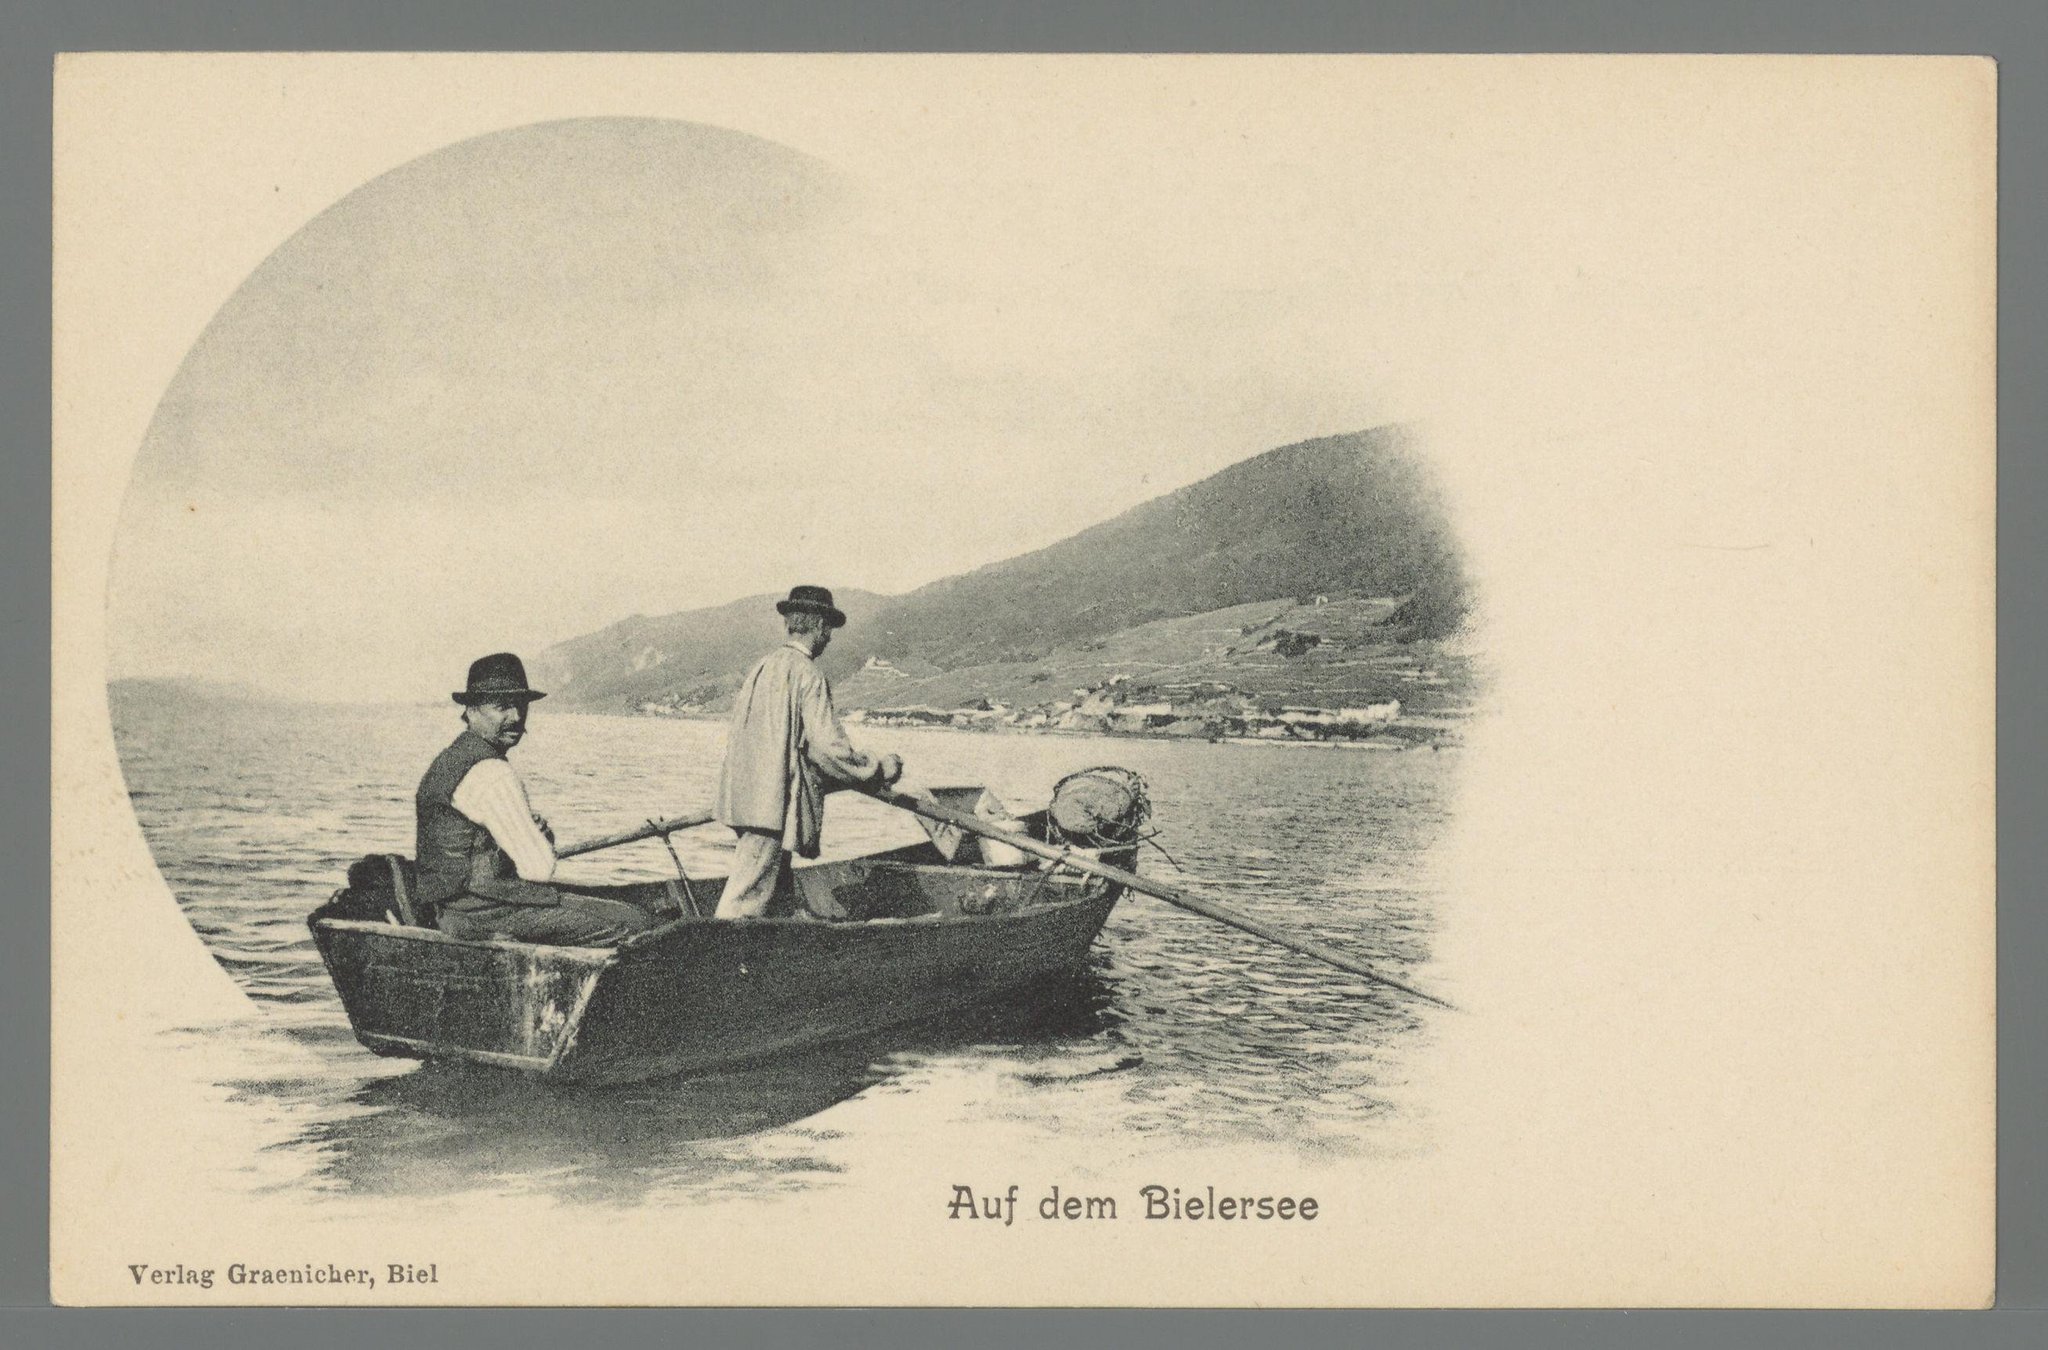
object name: photomechanical print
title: Auf dem Bielersee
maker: Anonymous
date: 1892-1900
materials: cardboard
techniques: photograph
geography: biel/bienne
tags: rowing-boat, canoe, etc. (+ two persons ~ traffic and transport), lake (+ landscape with figures, staffage)